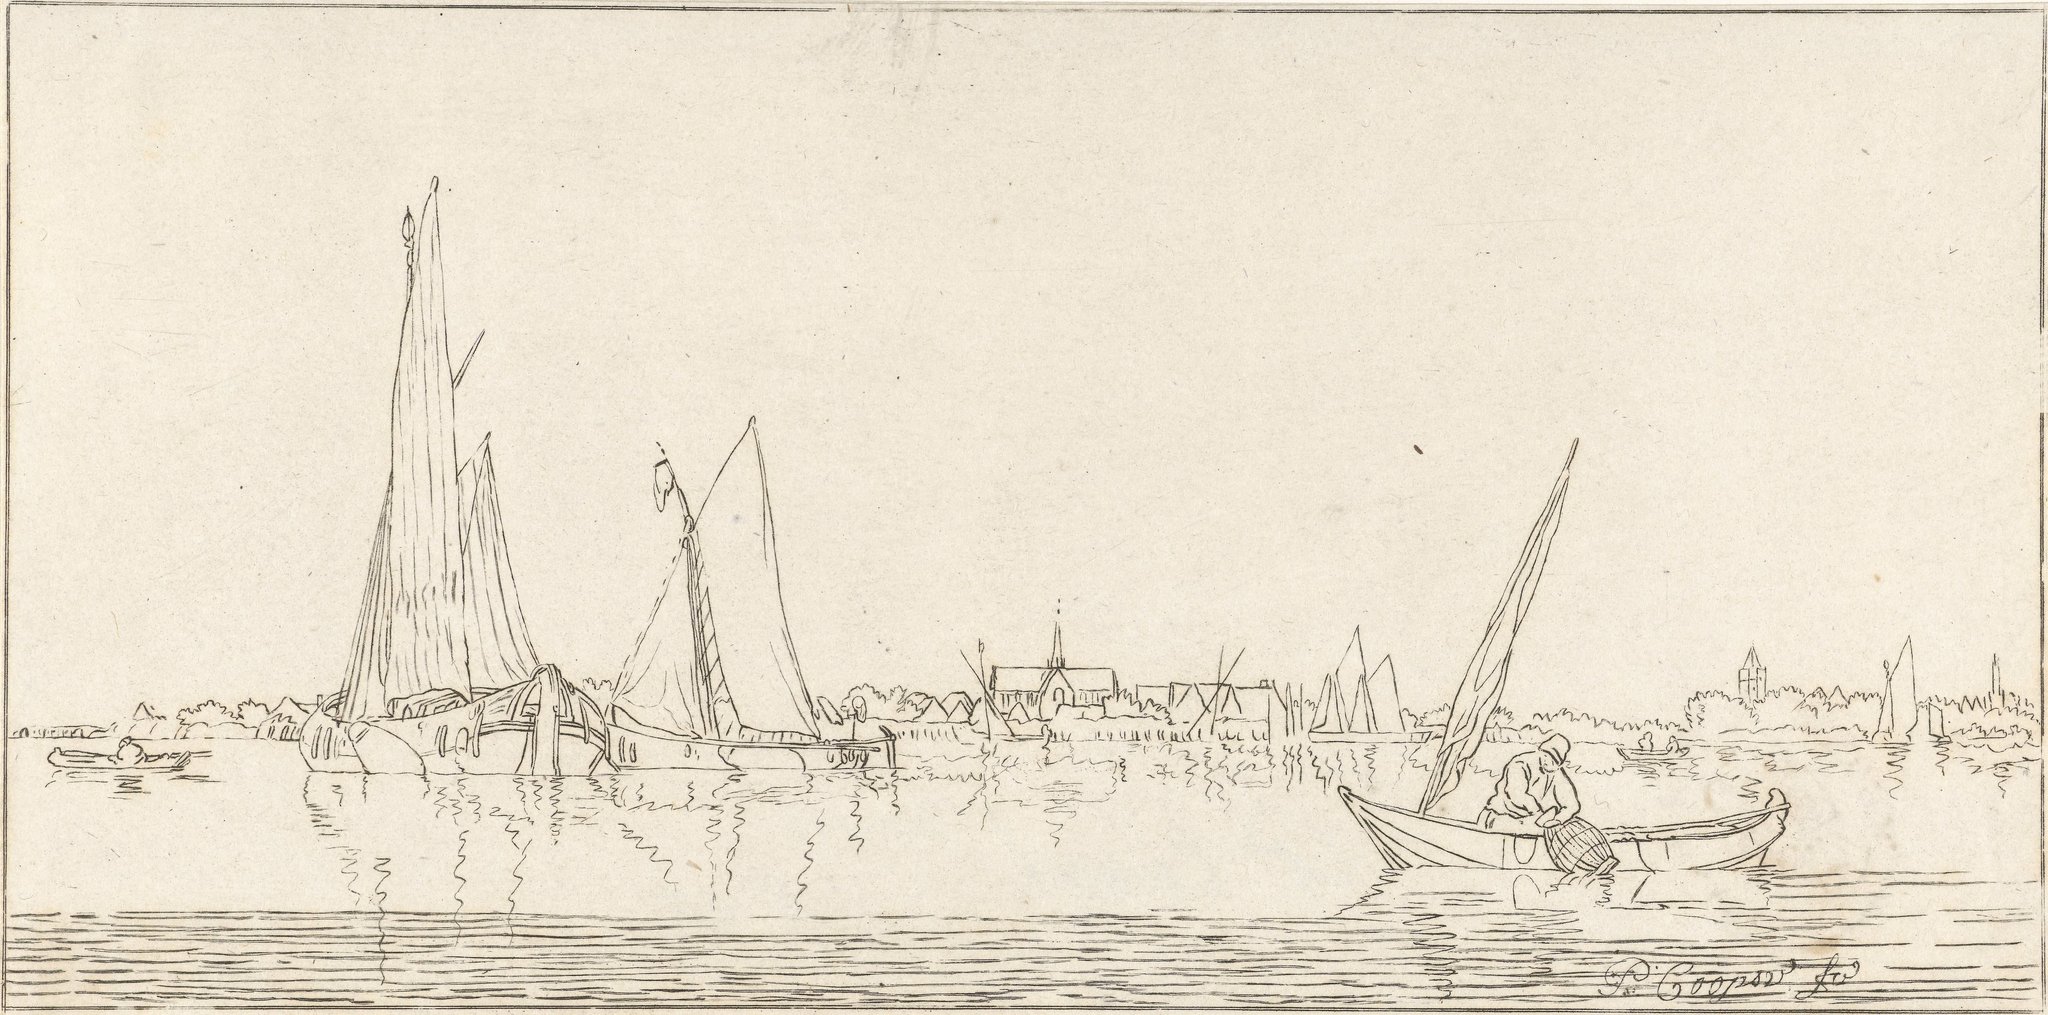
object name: print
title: Riviergezicht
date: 1775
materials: paper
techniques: etching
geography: amsterdam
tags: sailing-ship, sailing-boat, river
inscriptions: collector's mark: Lugt 240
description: Op het water varen zeilschepen. Aan de horizon een stad met een kerk.